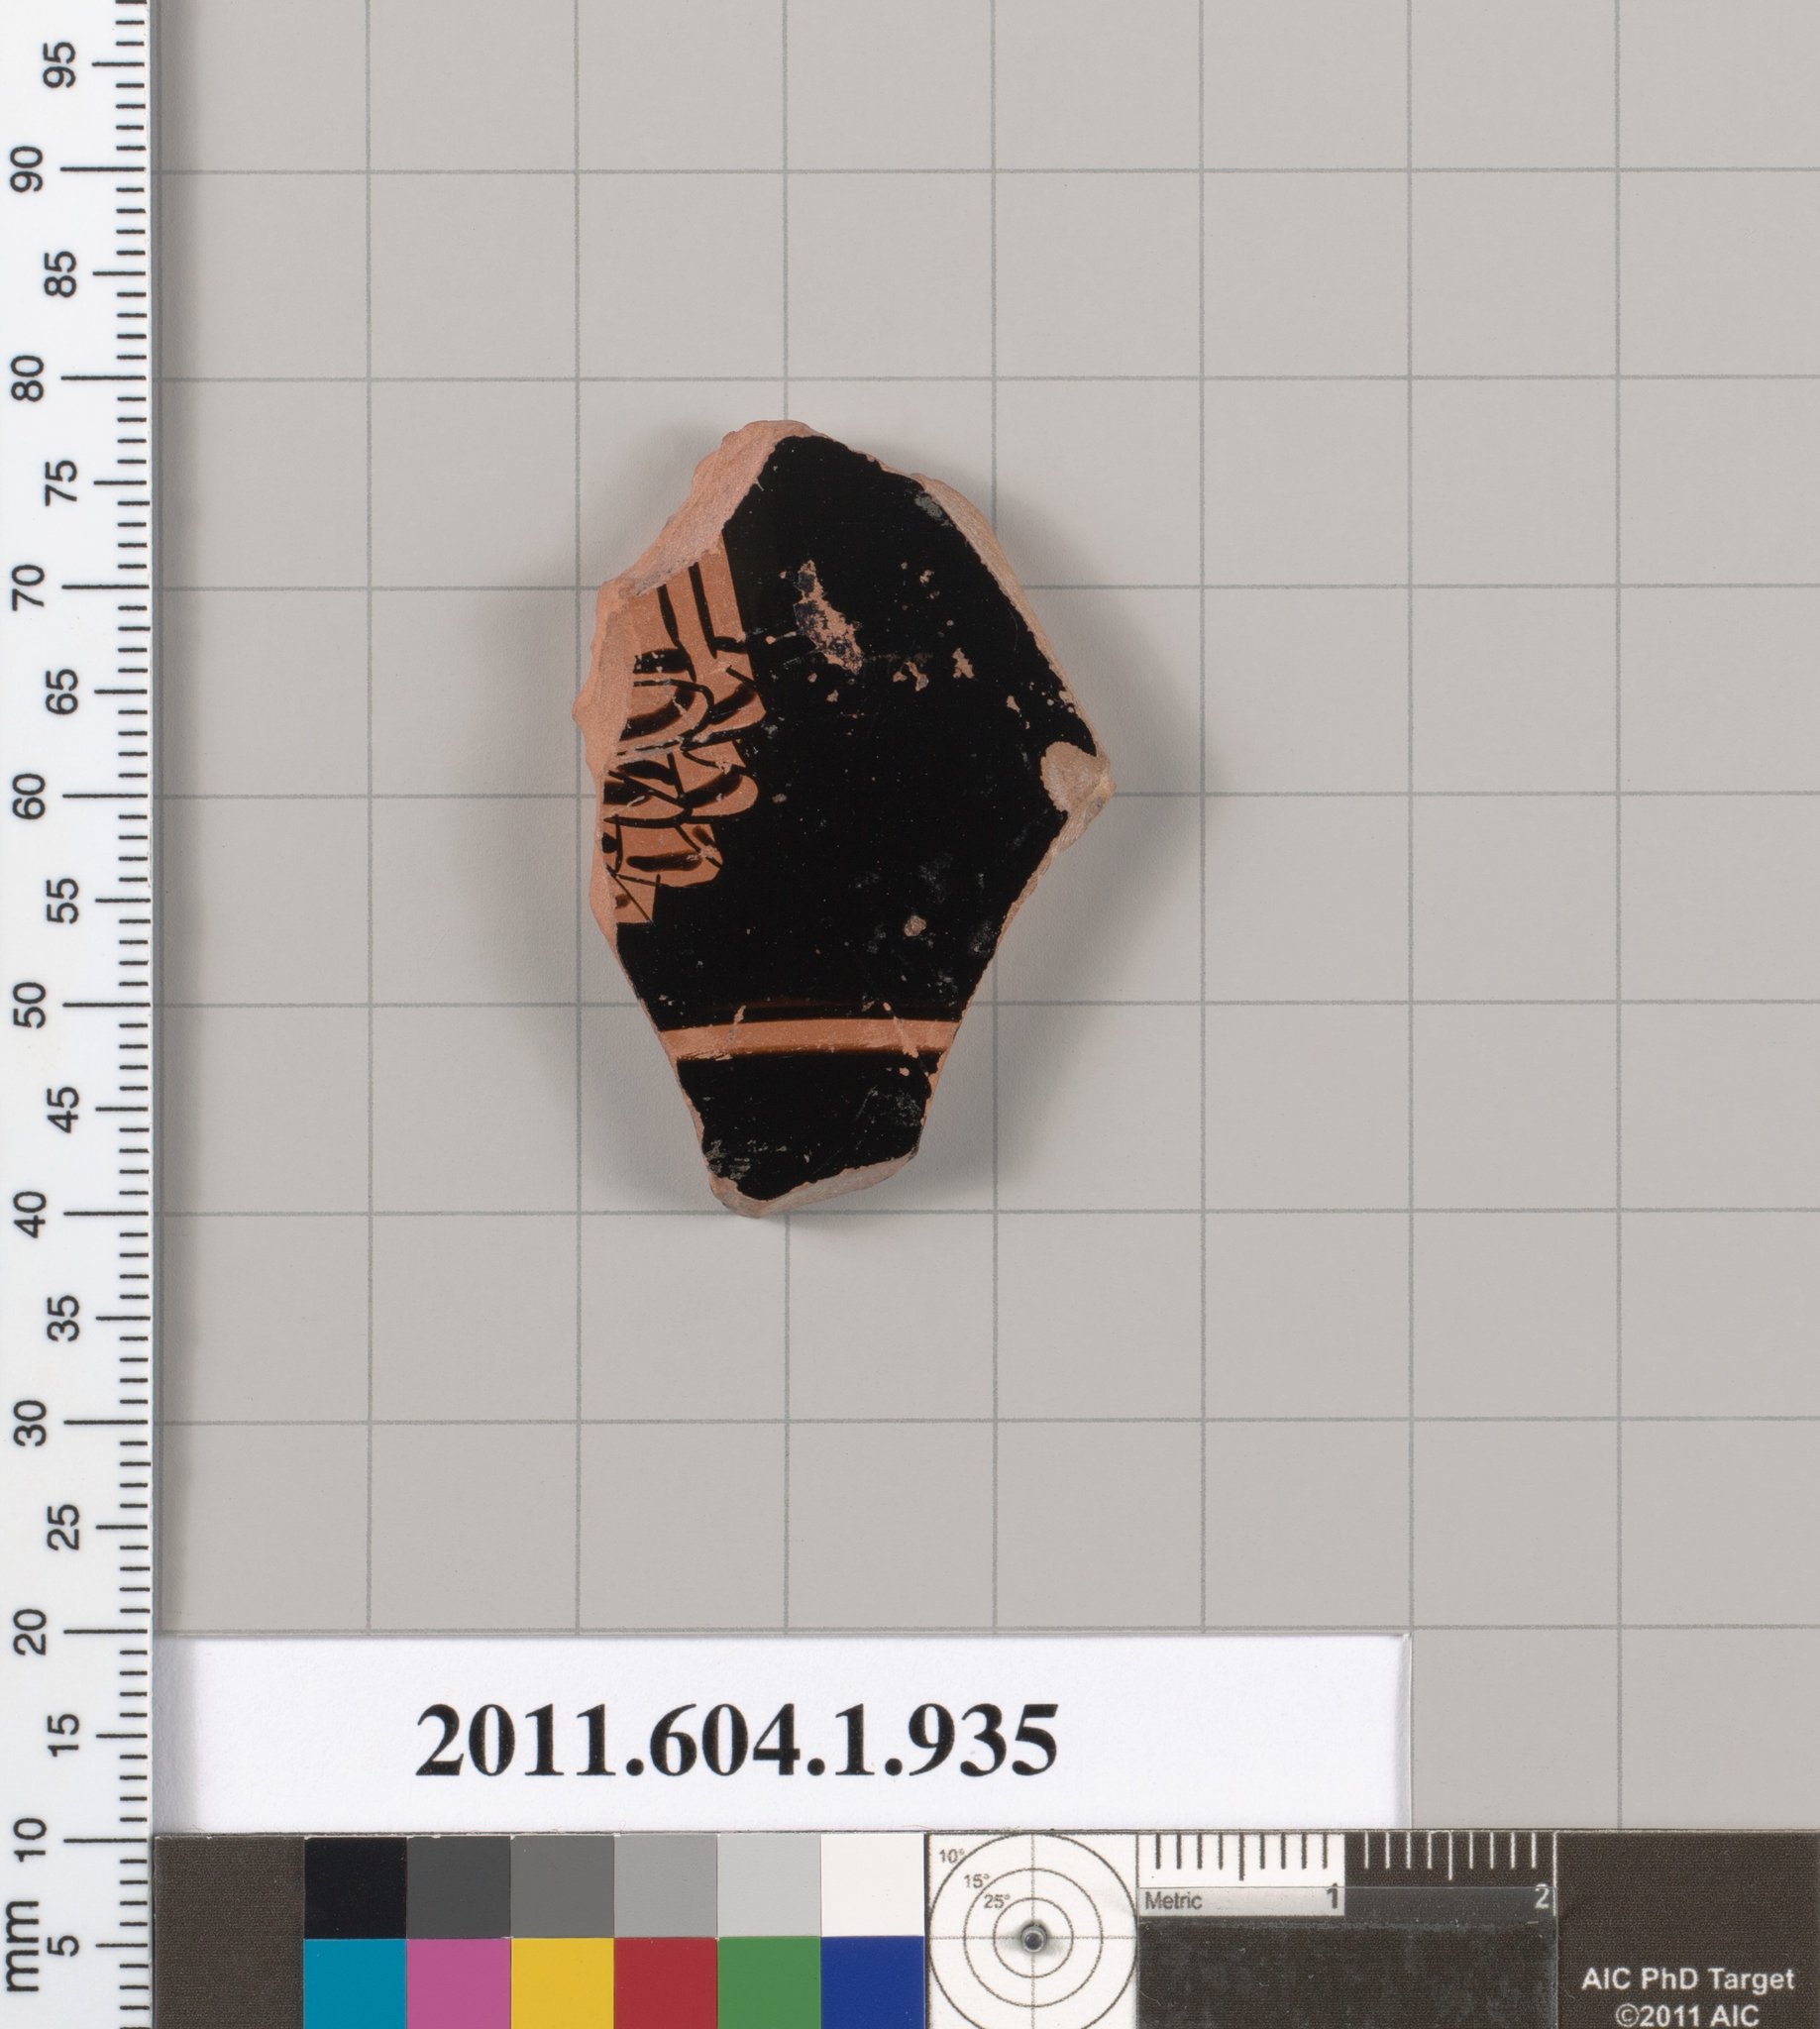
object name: kylix fragment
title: Terracotta fragment of a kylix (drinking cup)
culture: greek, attic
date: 490-480 BCE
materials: terracotta